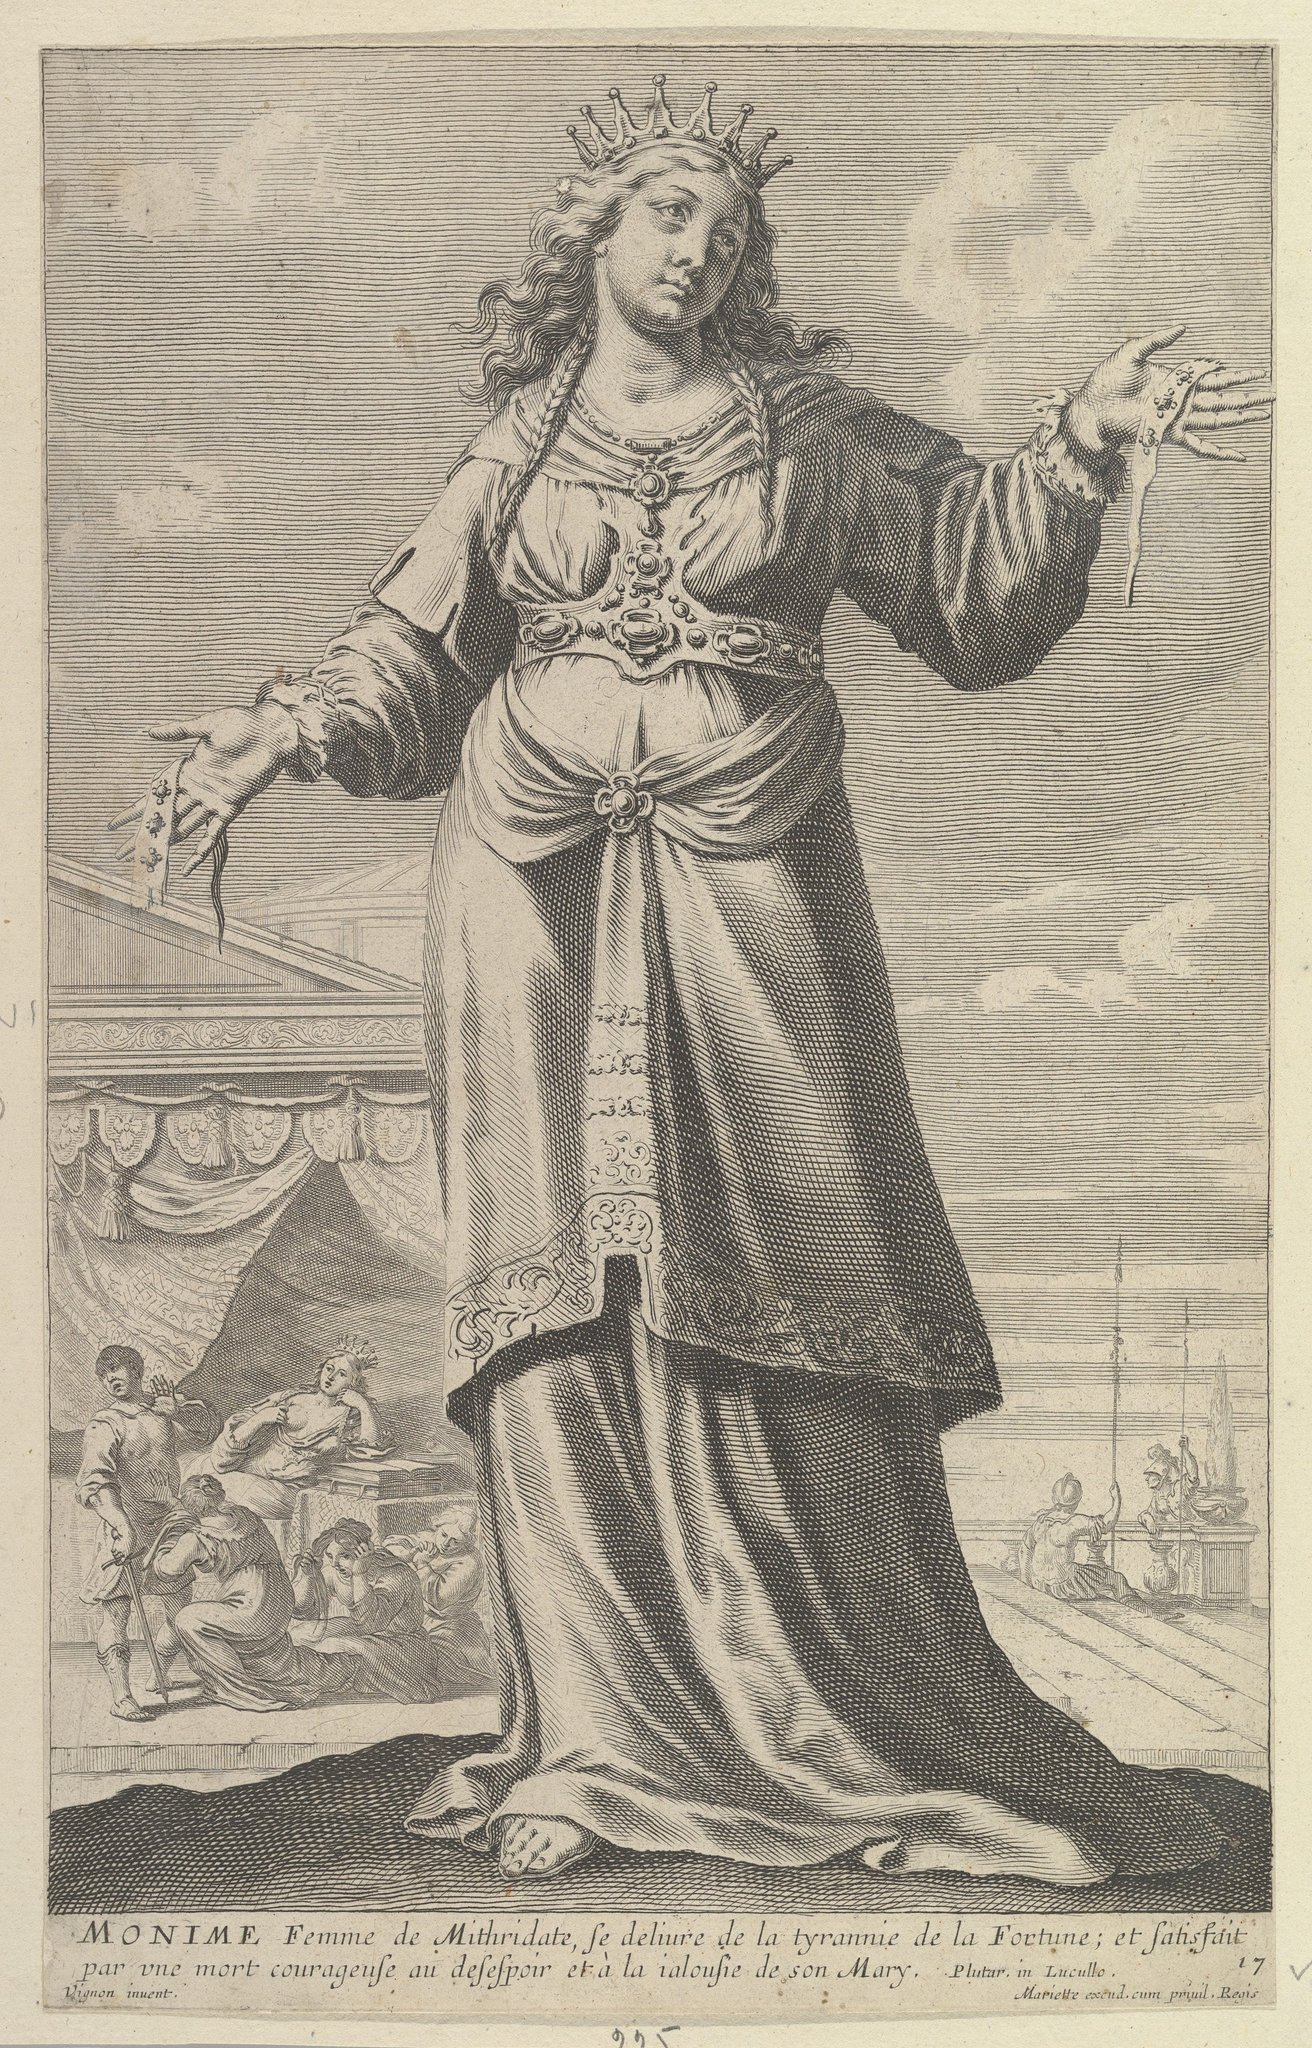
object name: print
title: Monime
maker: gilles rousselet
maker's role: artist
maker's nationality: french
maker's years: 1614-1686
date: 1647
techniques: engraving, etching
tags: women